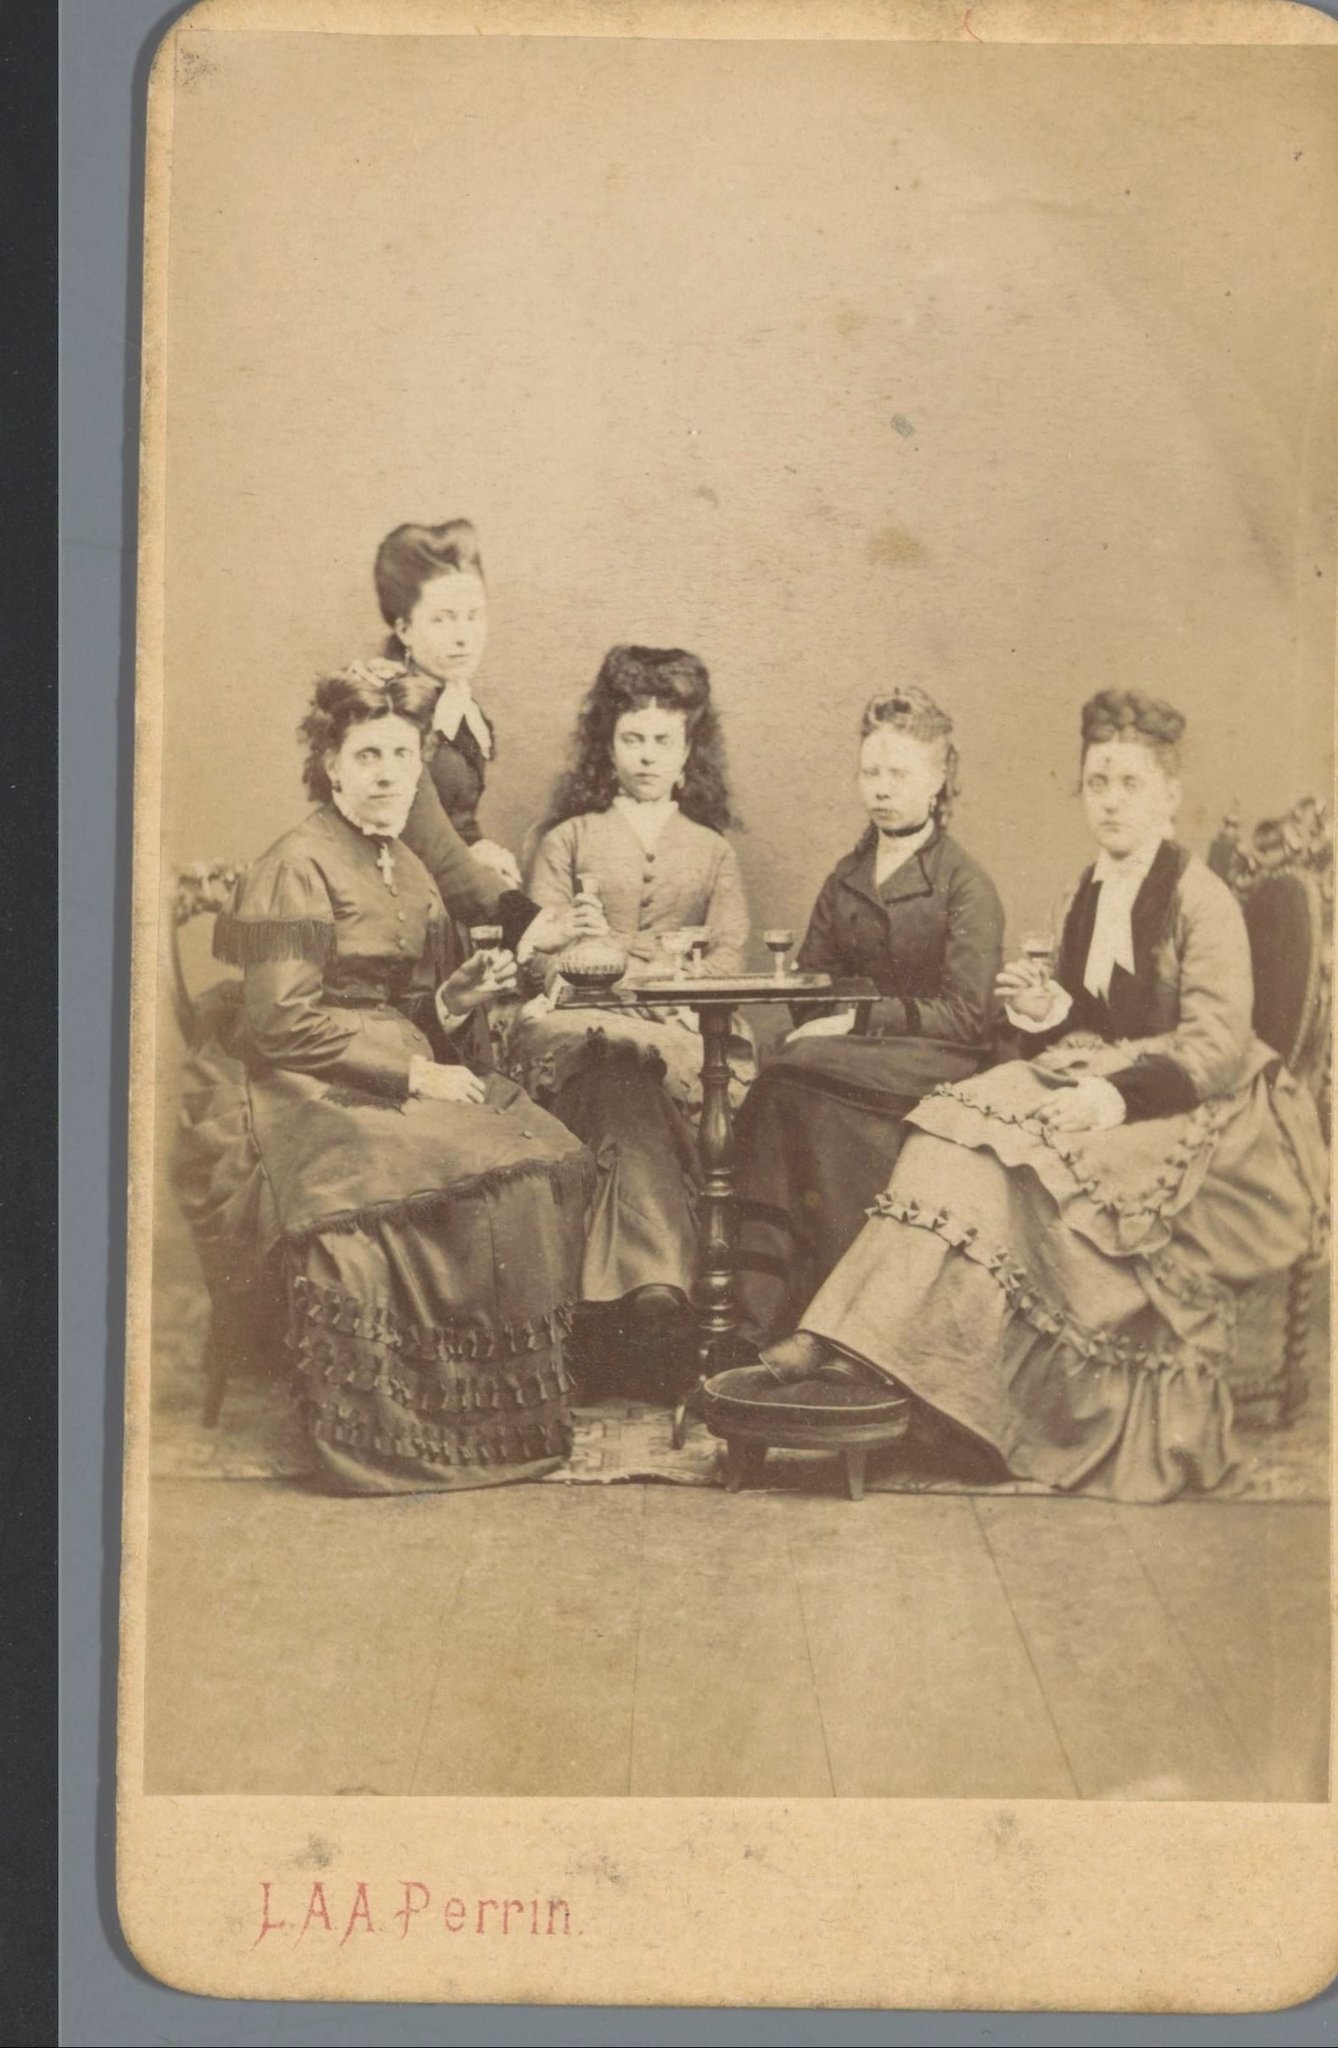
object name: photograph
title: Groepsportret van vijf onbekende vrouwen rond een tafel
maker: louis adrien alexandre perrin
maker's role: fotograaf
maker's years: 1837-1890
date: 1868-1874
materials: cardboard, paper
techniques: albumen print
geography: alkmaar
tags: adult woman, anonymous historical persons portrayed in a group, in a group-portrait - bb - woman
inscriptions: inscription: ‘Photographisch/ Atelier/ van/ L.A.A. Perrin./ Laat,/ Wijk A.484 over de Roomsche Kerk./ te/ Alkmaar’, inscription: ‘L.A.A. Perrin’